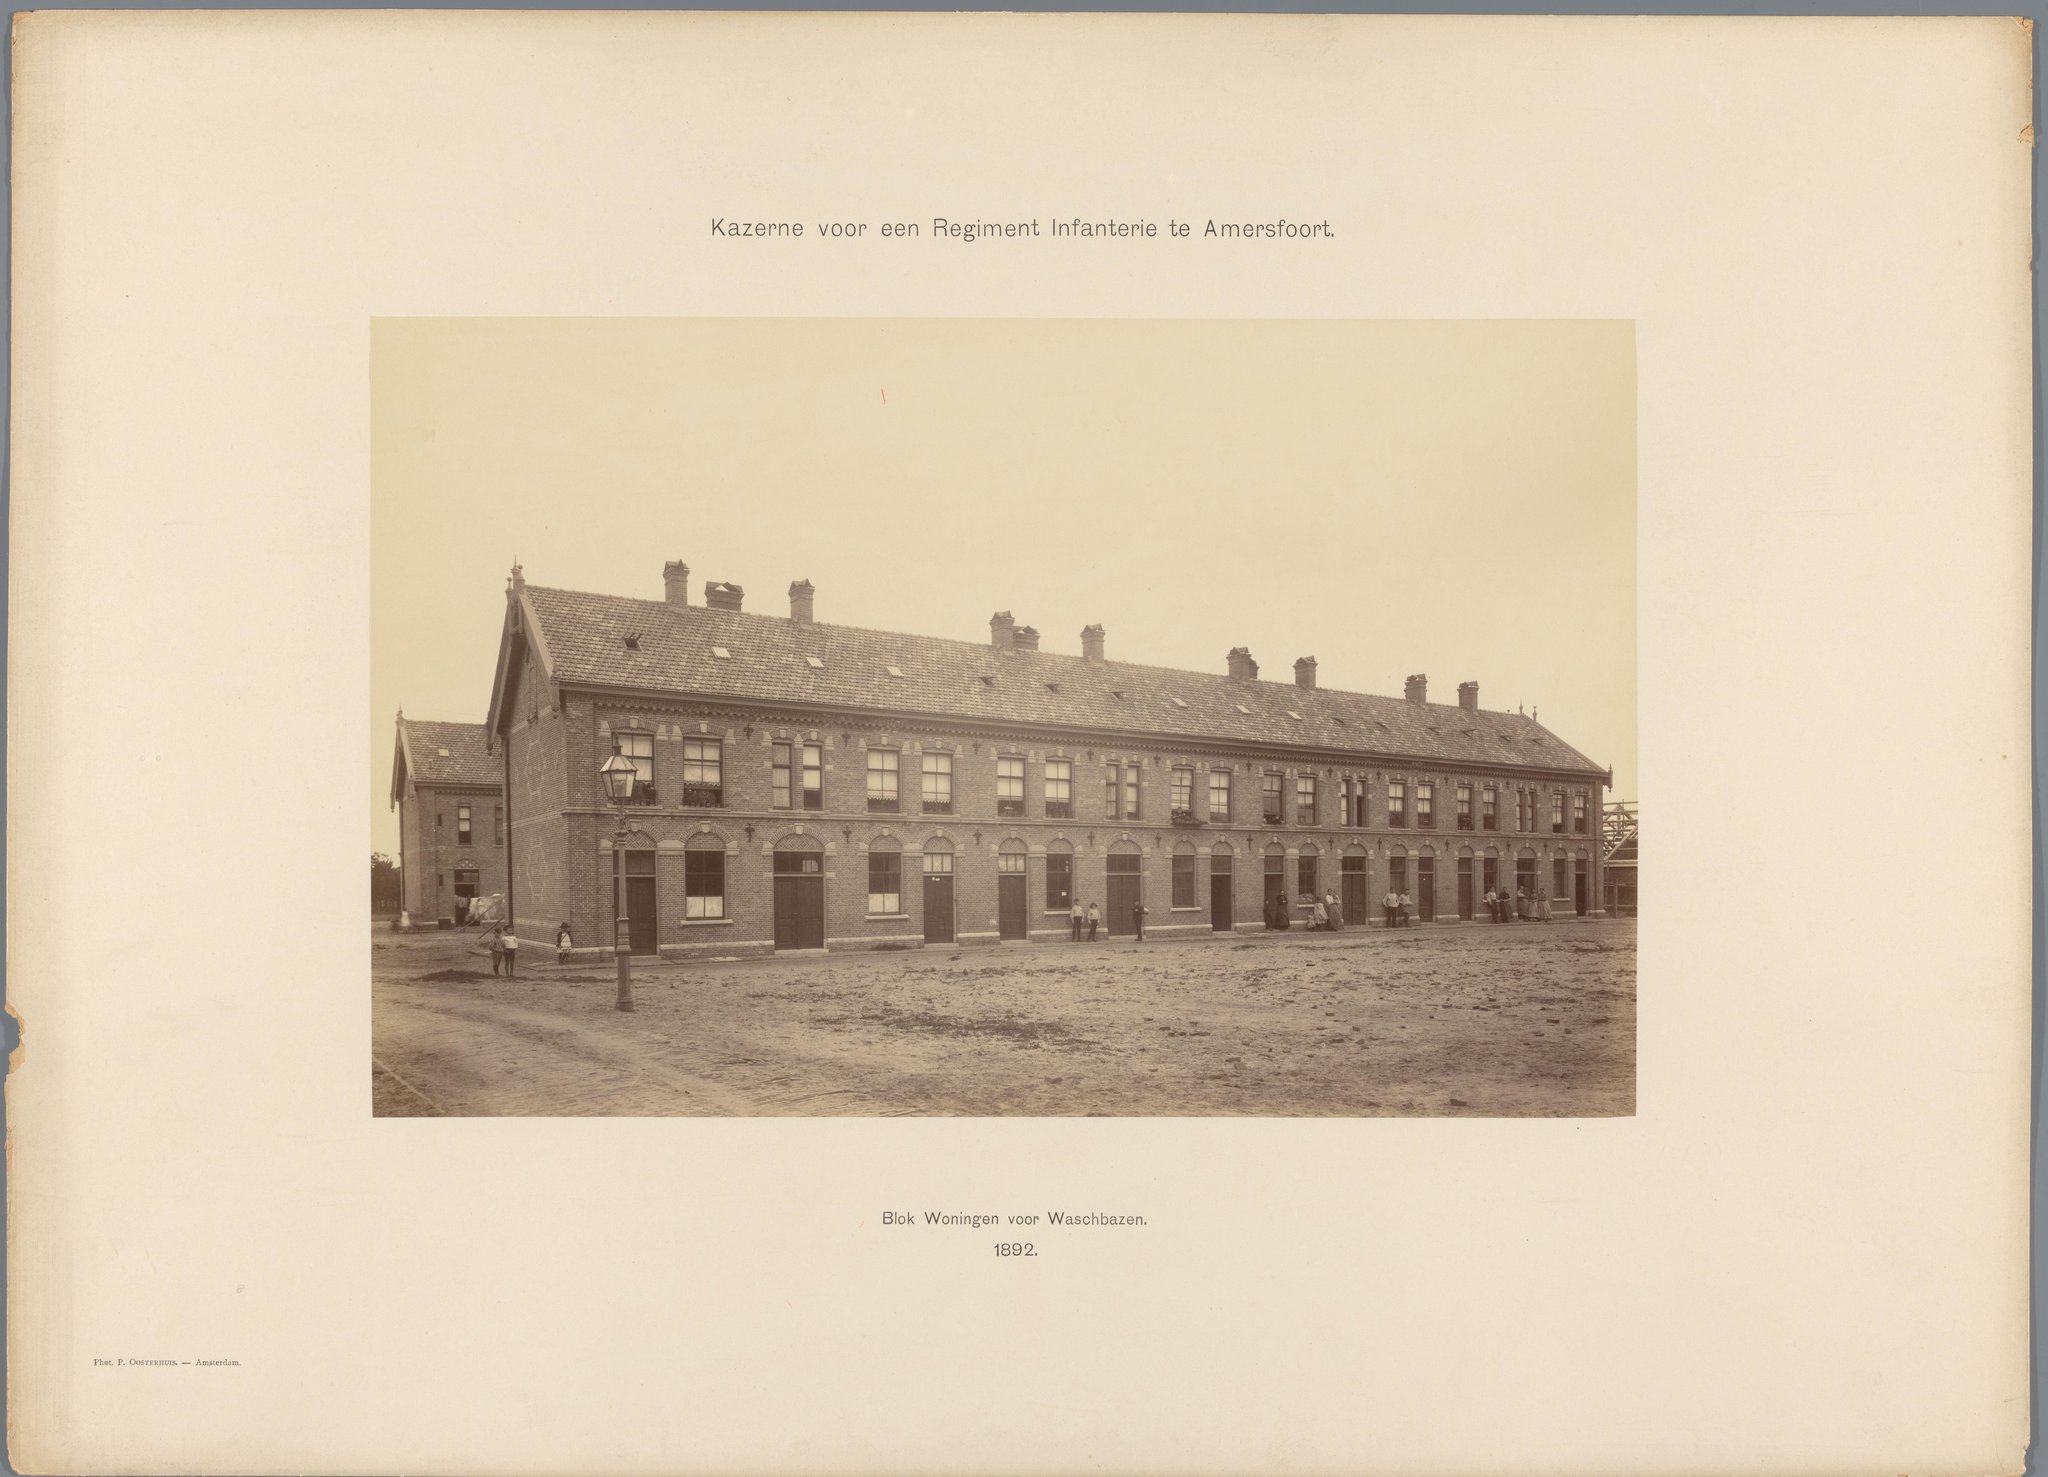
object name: photograph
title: Kazerne voor een Regiment Infanterie te Amersfoort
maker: p. oosterhuis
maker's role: fotograaf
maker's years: 1816-1885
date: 1892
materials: cardboard, paper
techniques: photography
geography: amersfoort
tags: netherlands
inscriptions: date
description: Foto, geelbruin, op karton, met boven titel en onder omschrijving. Opschrift; m.o.: 'Blok woningen voor Waschbazen'.